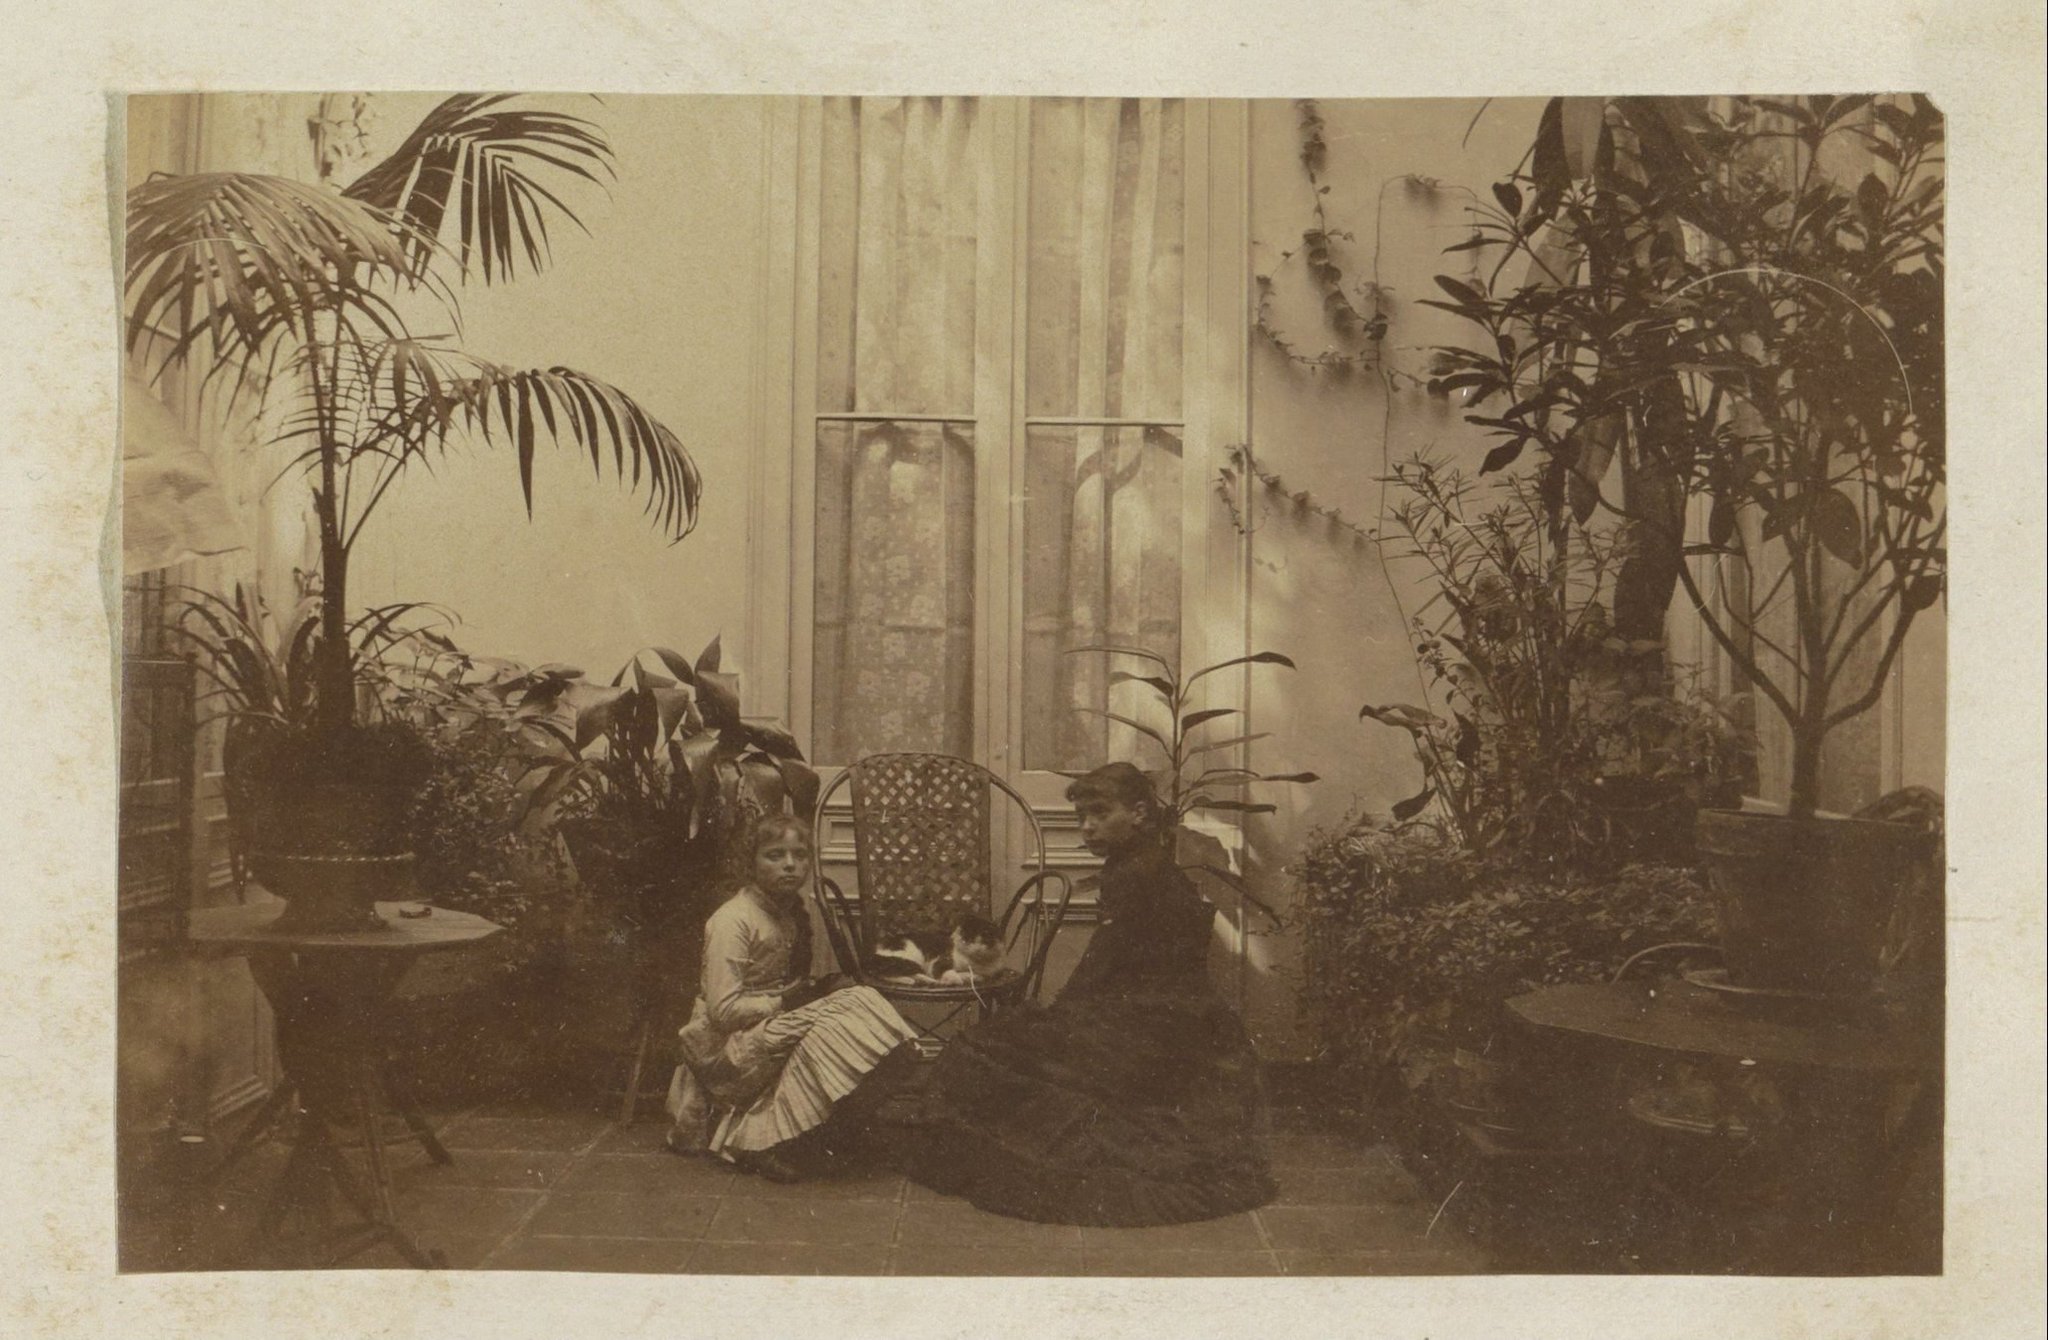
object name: photograph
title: Twee meisjes zittend bij een kat op een binnenplaats in Frankrijk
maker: Anonymous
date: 1808-1883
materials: photographic support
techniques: albumen print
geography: france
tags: adolescent, young woman, maiden, cat, courtyard, france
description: Onderdeel van Album van een Franse amateurfotograaf met opnames van familie, militairen, industrie, landschappen en bezienswaardigheden in Frankrijk.